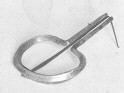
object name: jew's harp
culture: russian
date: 1801-1900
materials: iron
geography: russia